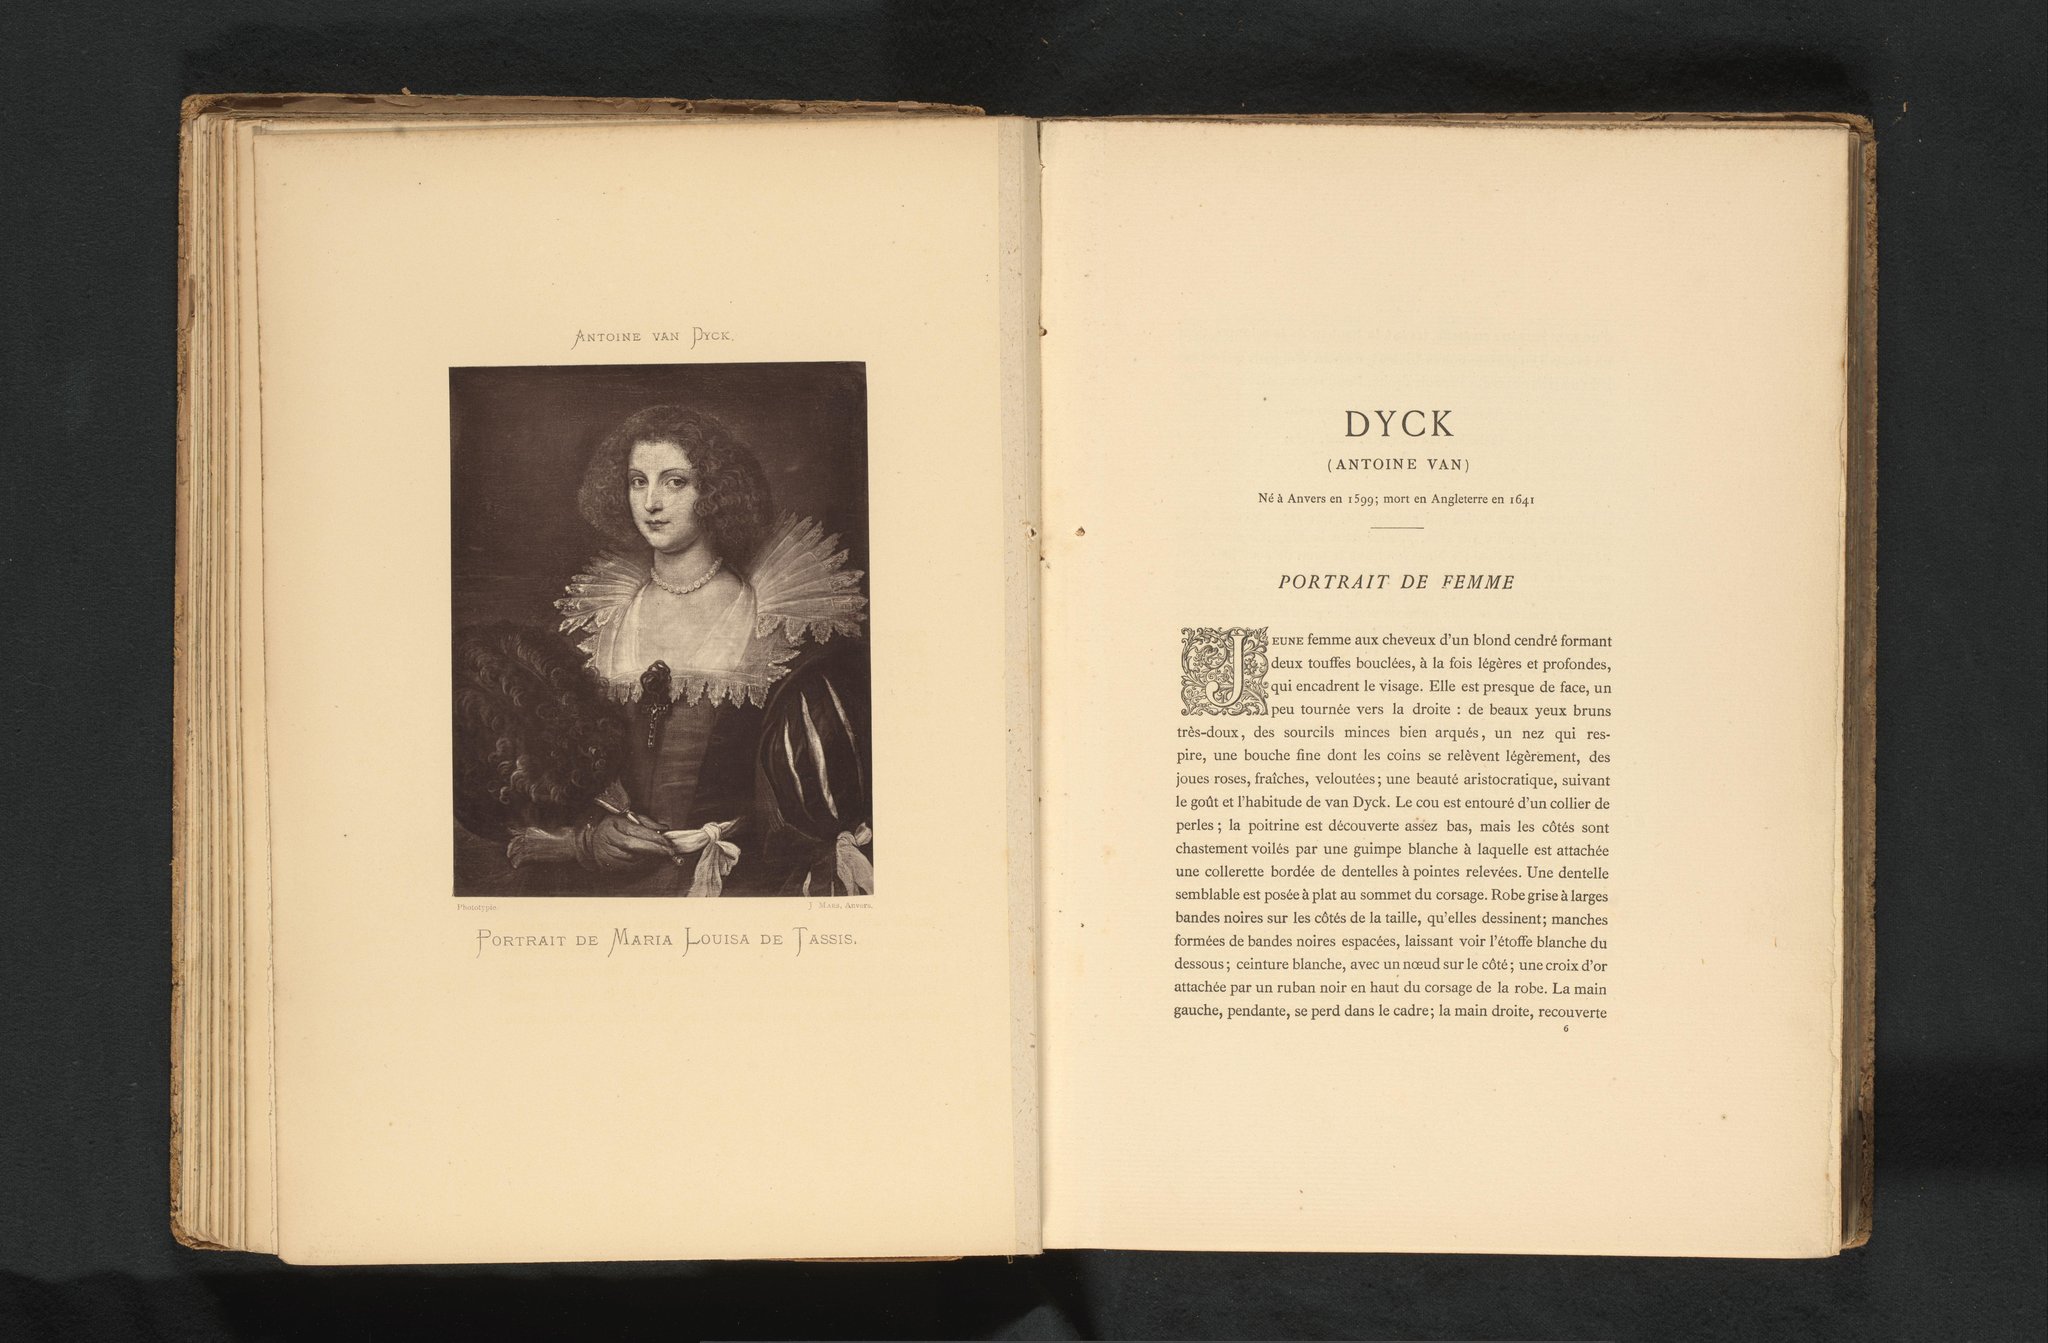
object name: page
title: Portrait de Maria Louisa de Tassis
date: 1873-1878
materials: paper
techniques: woodburytype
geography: antwerp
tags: historical persons - bb - woman